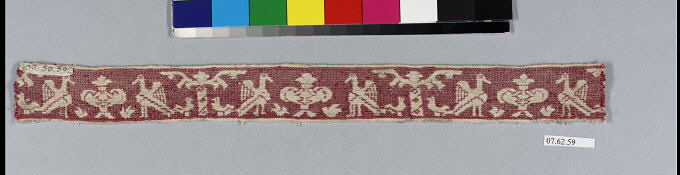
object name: band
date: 1601-1700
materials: linen, silk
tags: birds